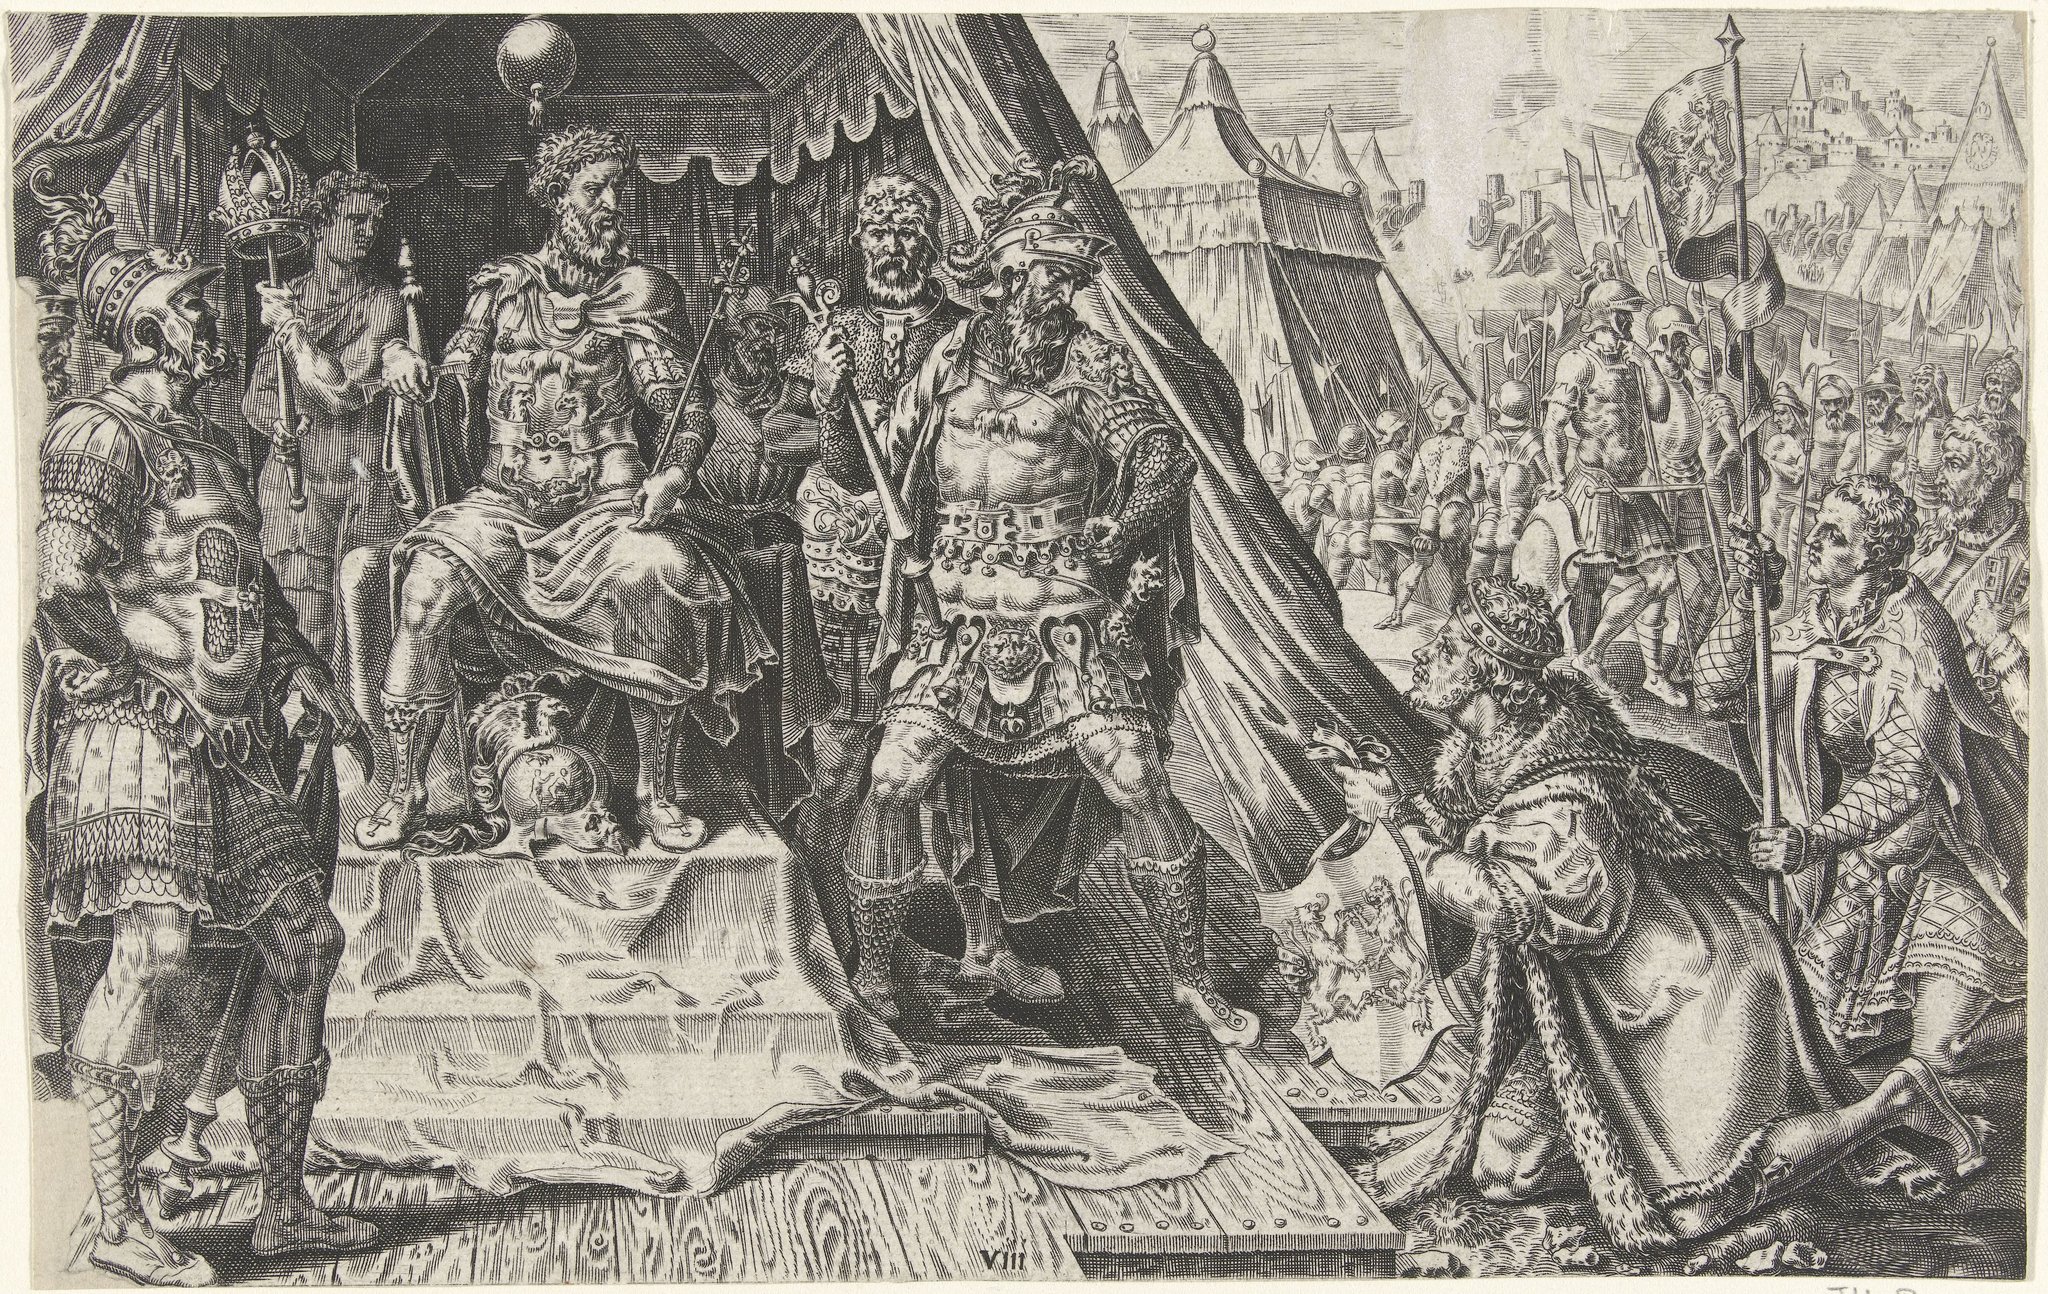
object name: print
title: Overwinningen van Karel V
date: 1555-1556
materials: paper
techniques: engraving, etching, letterpress printing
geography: haarlem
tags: ghent, charles v (holy roman emperor and king of spain)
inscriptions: collector's mark: Lugt 2228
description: Tijdens de Vrede van Venlo (1543) knielt de hertog van Gelre, Willem II, voor de troon van keizer Karel V en onderwerpt zich aan zijn macht. Hij overhandigt hem het wapenschild van Gelre. De prent maakt deel uit van een twaalfdelige serie over de overwinningen van Karel V.